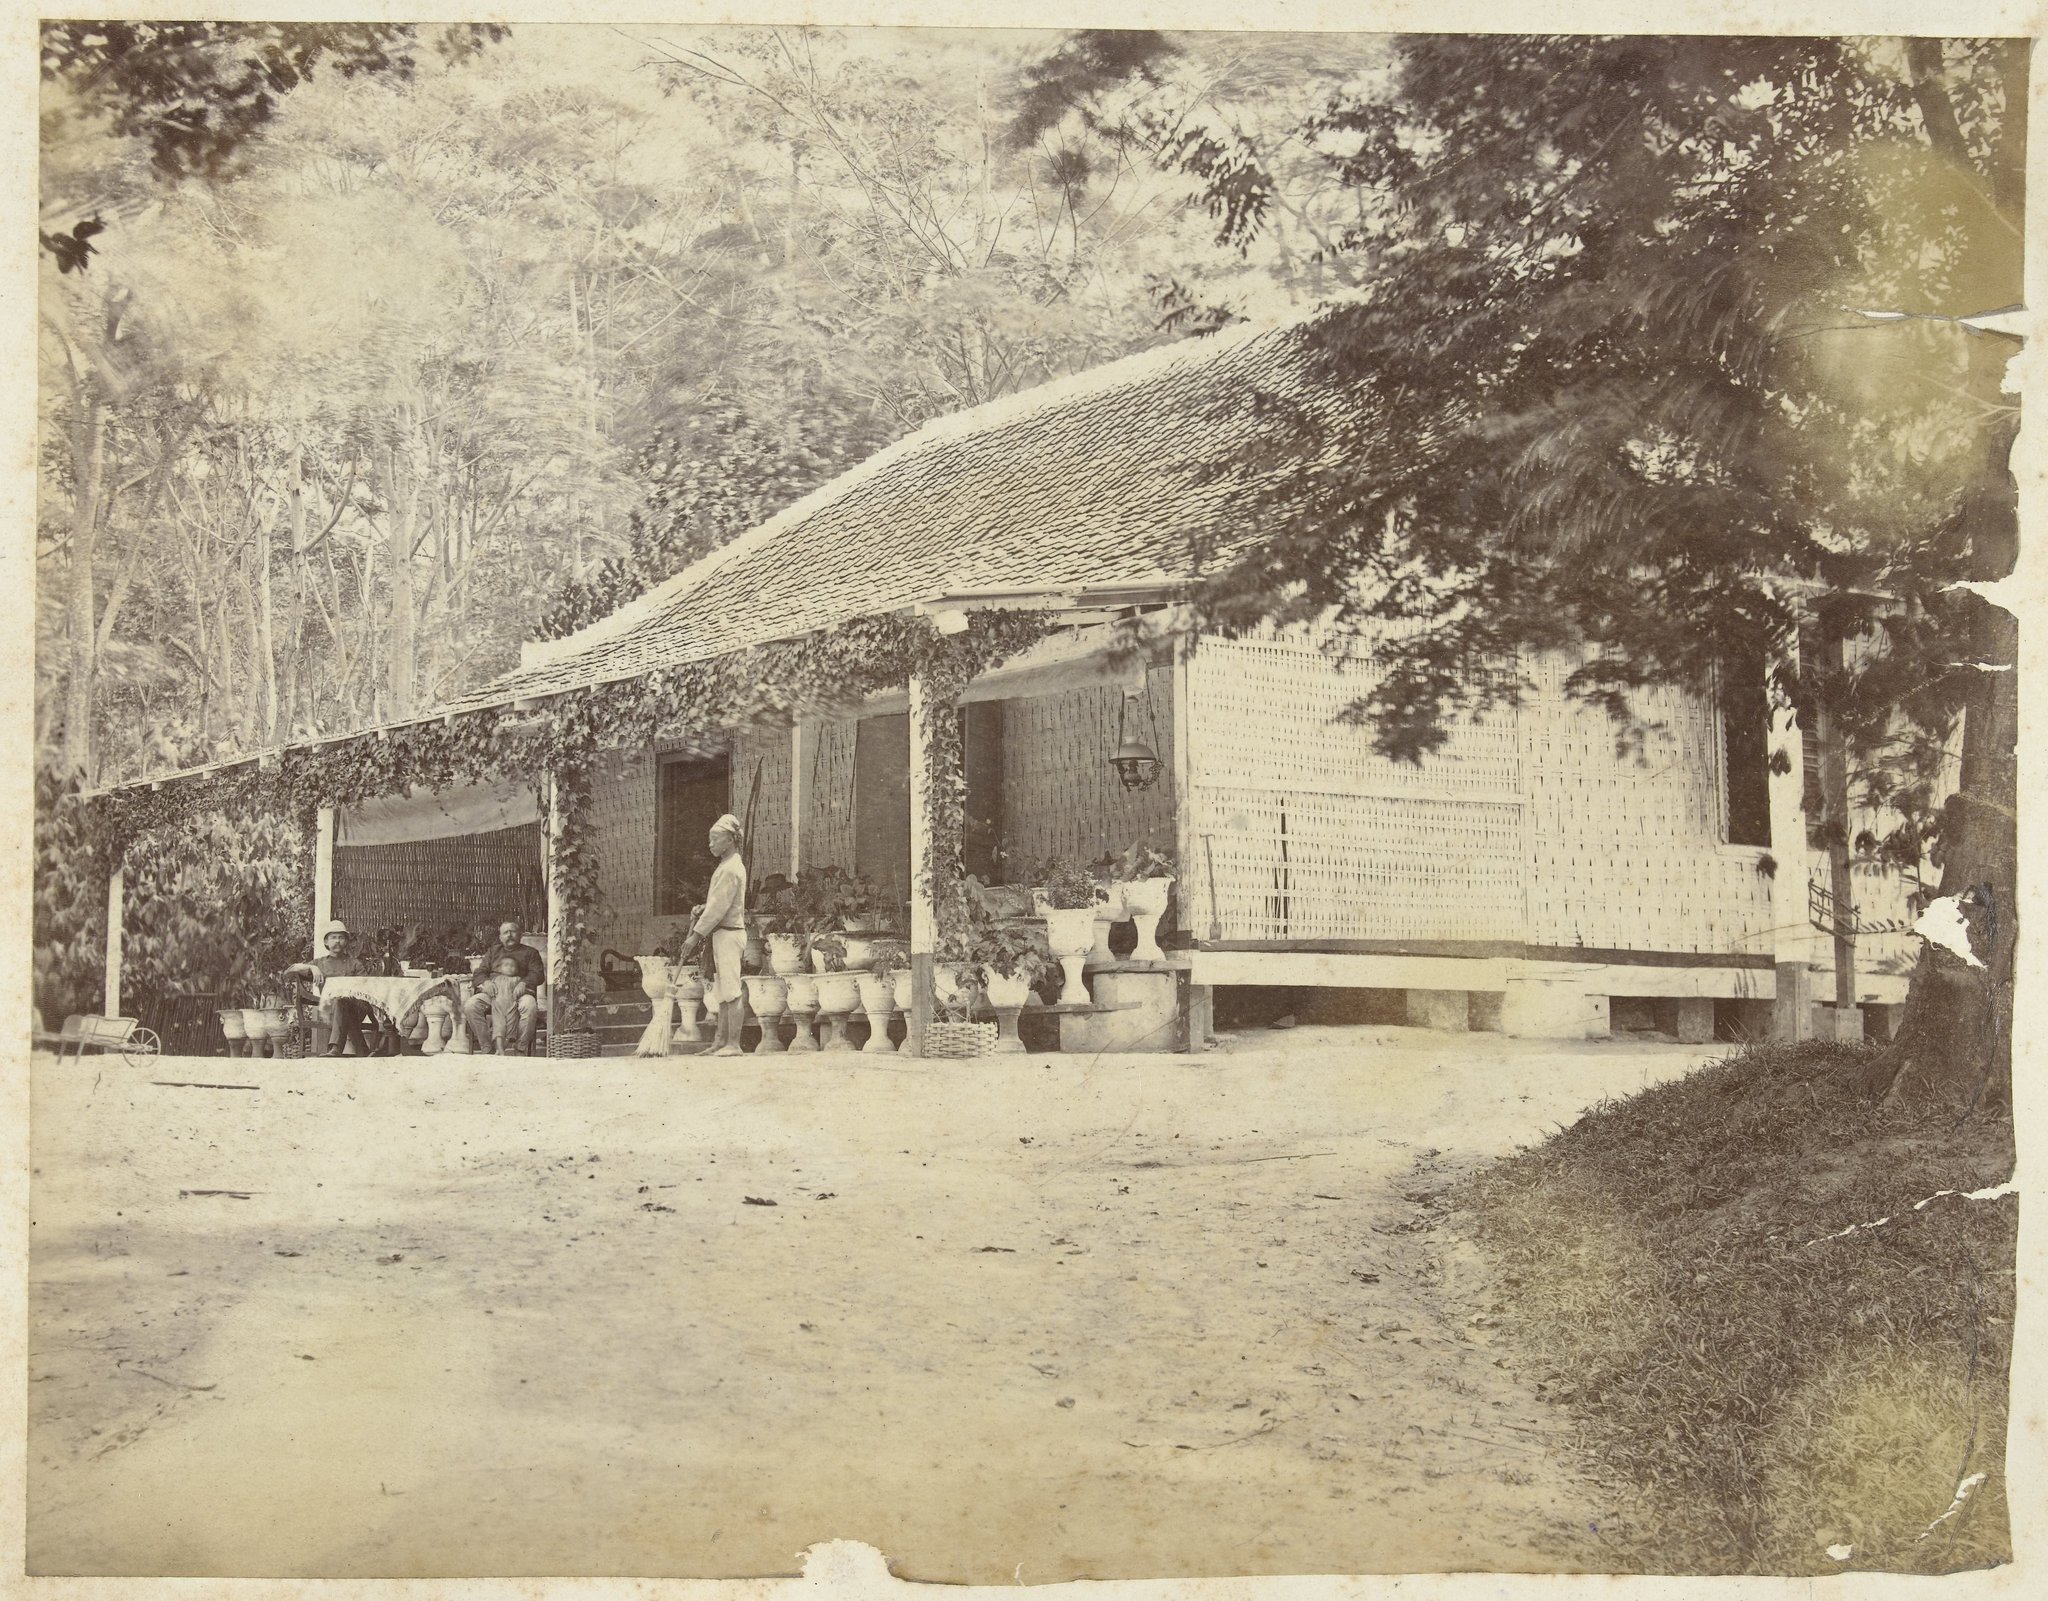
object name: photograph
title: Adm. woning Koffieland Karang Nongko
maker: Anonymous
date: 1890-1910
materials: cardboard, paper, photographic support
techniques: gelatin silver print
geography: singapore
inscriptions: caption: ‘Adm. woning Koffieland Karang Nongko’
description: Met aan tafel de administrateur met bezoek en voor de deur een werknemer die het pad veegt.